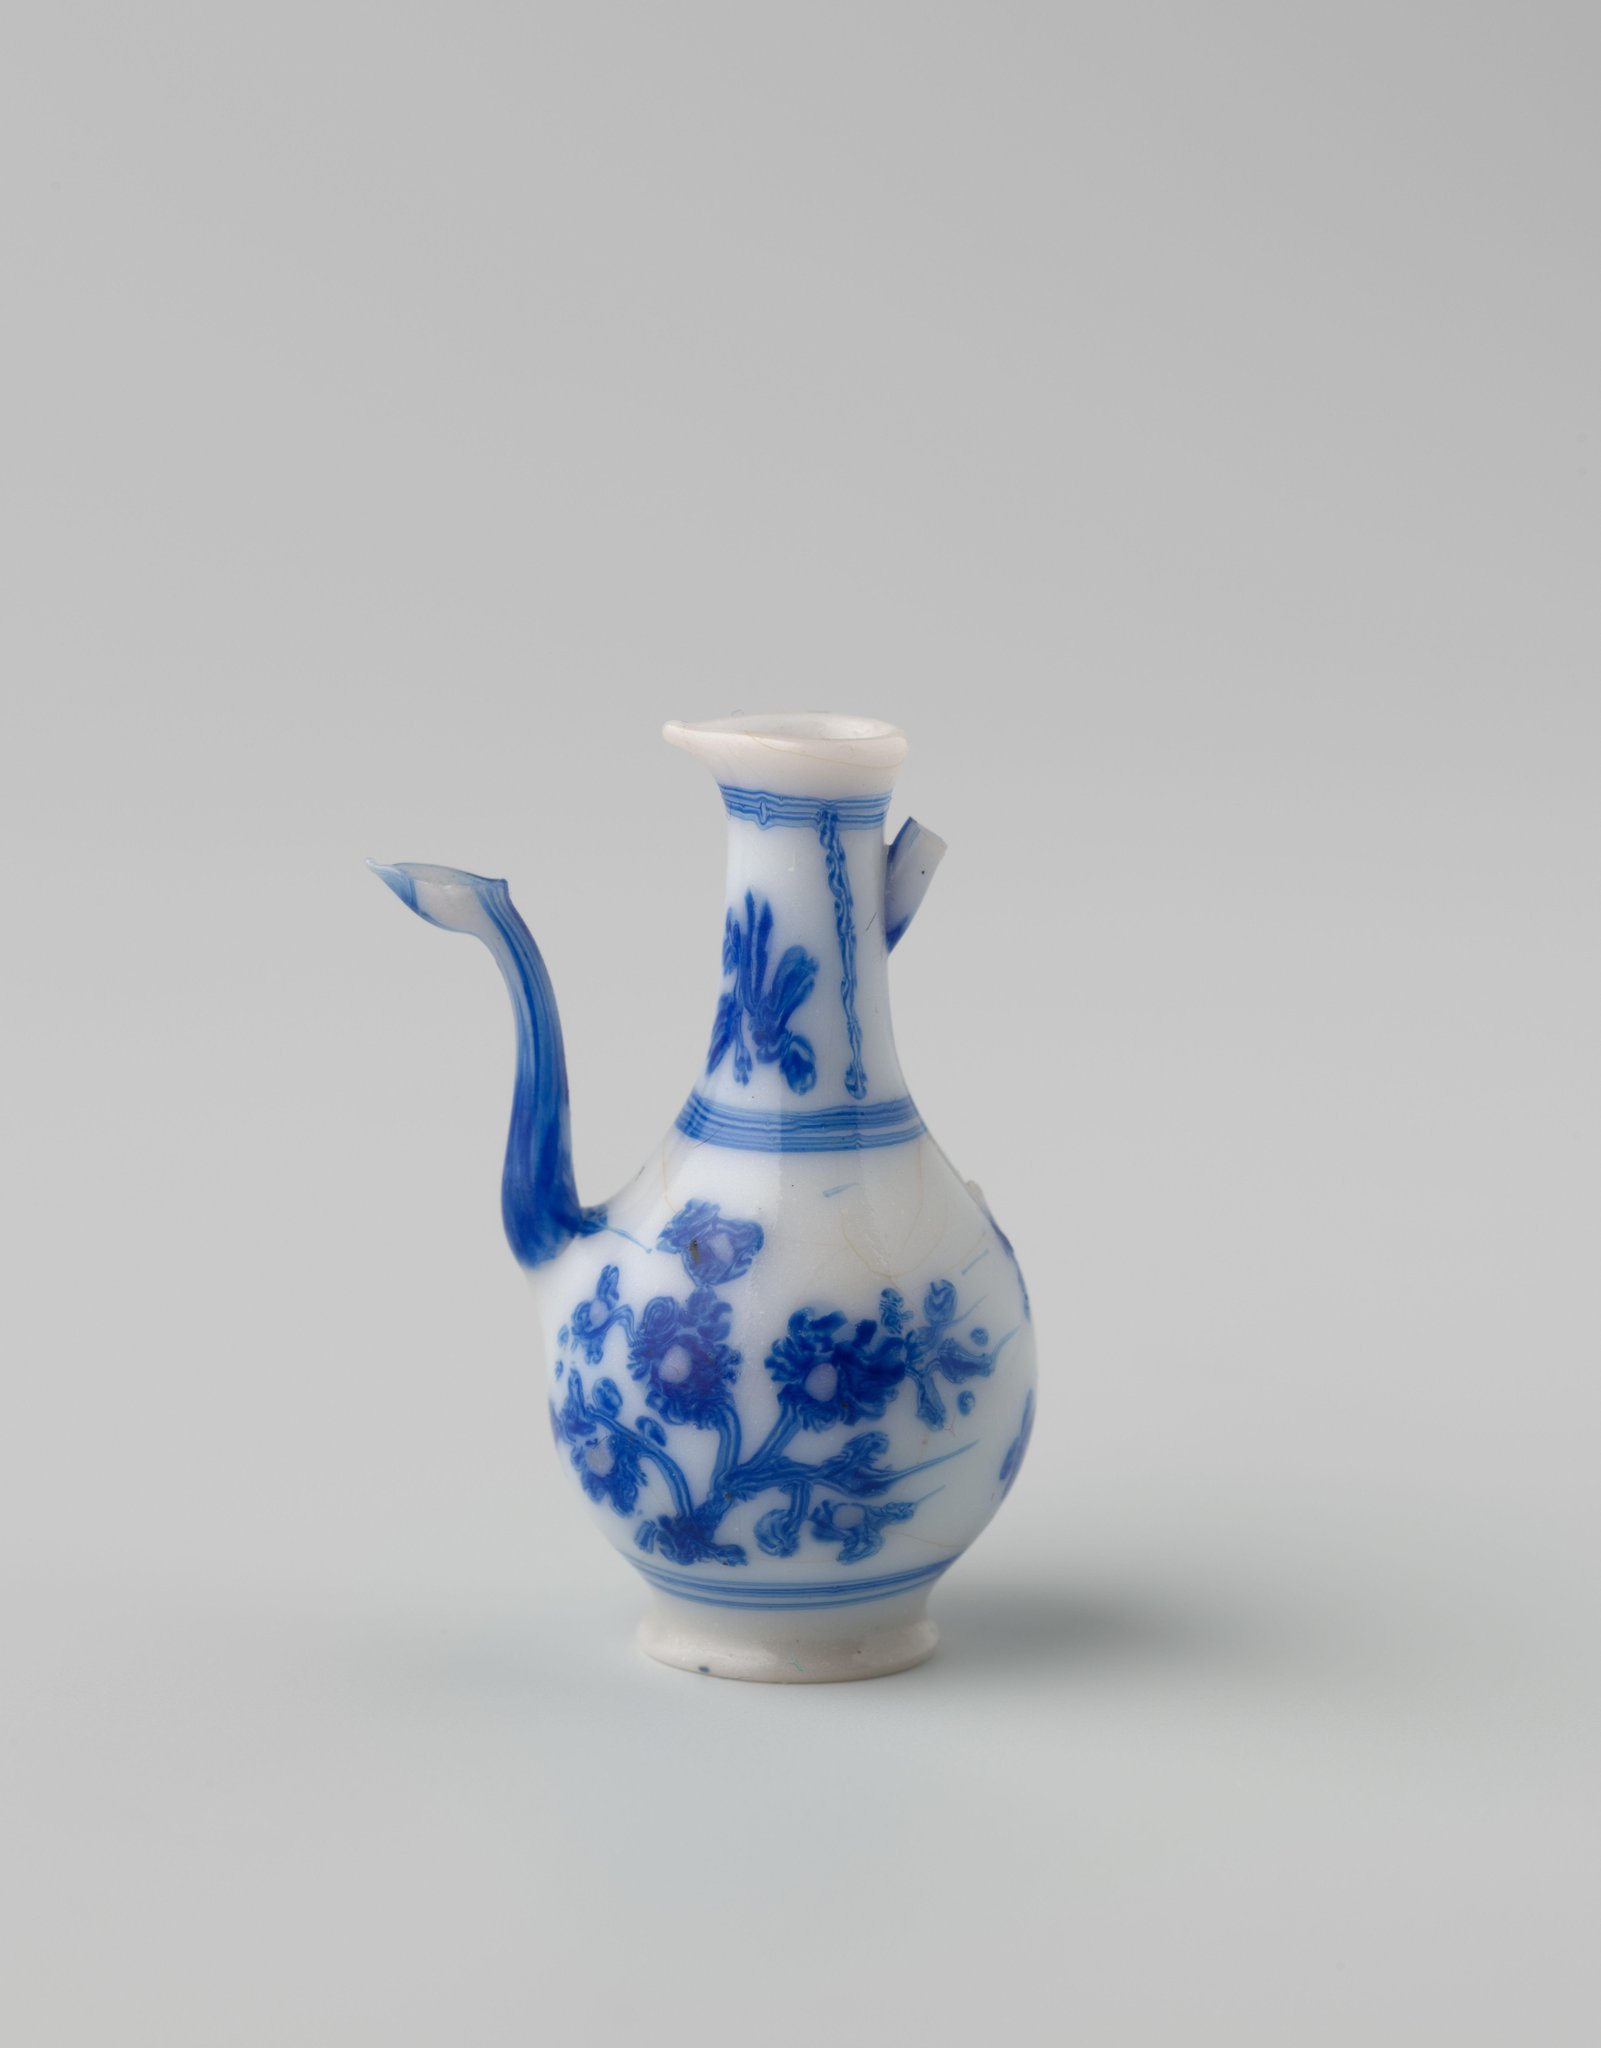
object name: miniature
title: Kan van melkglas met blauwe emailverf beschildering, imitatie Chinees porselein; decoratie van twee bloemtakken op de buik en bloemen in twee vakken op de hals. Peervormig.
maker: Anonymous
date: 1675-1710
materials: glass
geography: amsterdam